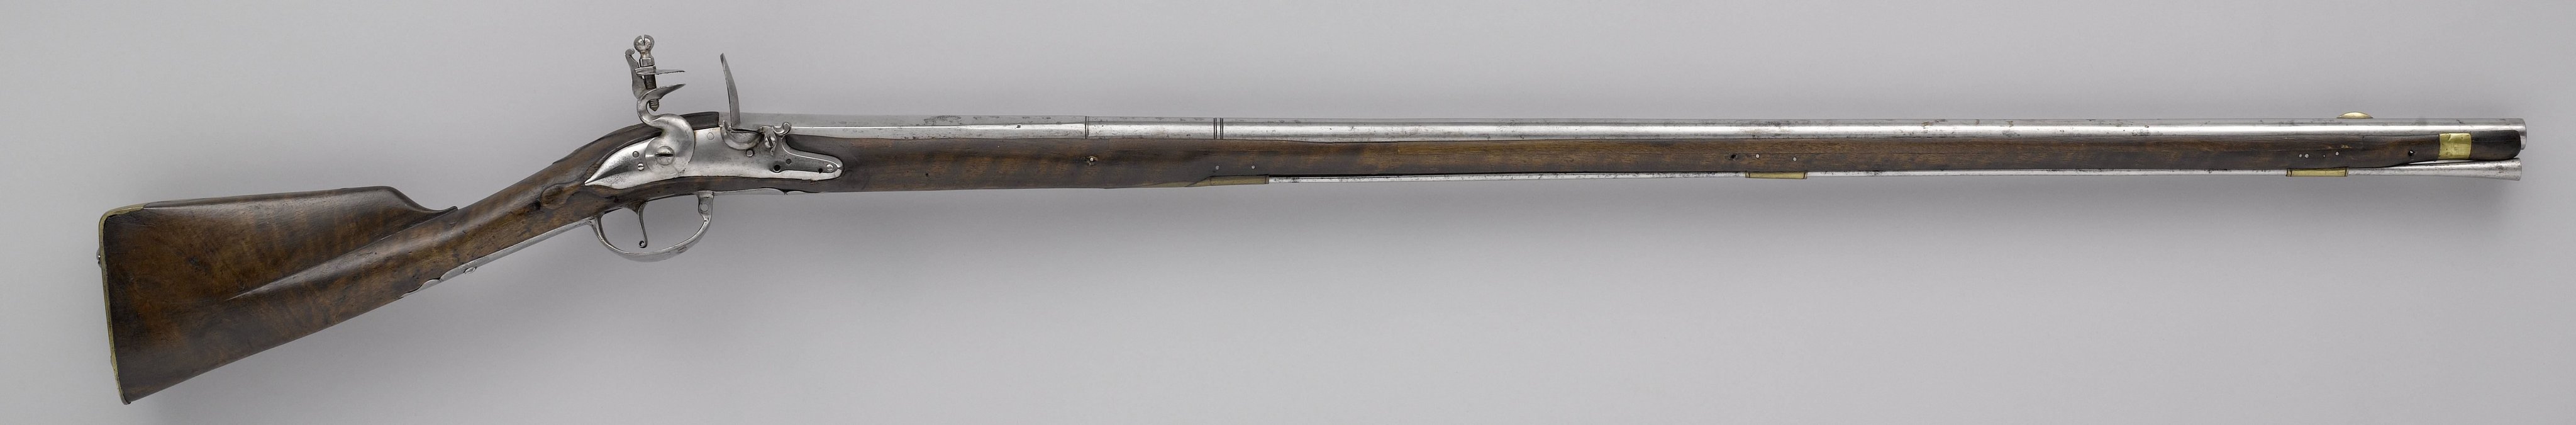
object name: flintlock pistol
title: Geweer van de VOC met wapen van Amsterdam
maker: solingen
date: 1725-1798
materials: copper, iron, wood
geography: amsterdam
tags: amsterdam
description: Geweer met vuursteenslot van de VOC en het wapen van Amsterdam. De laadstok is van ijzer.